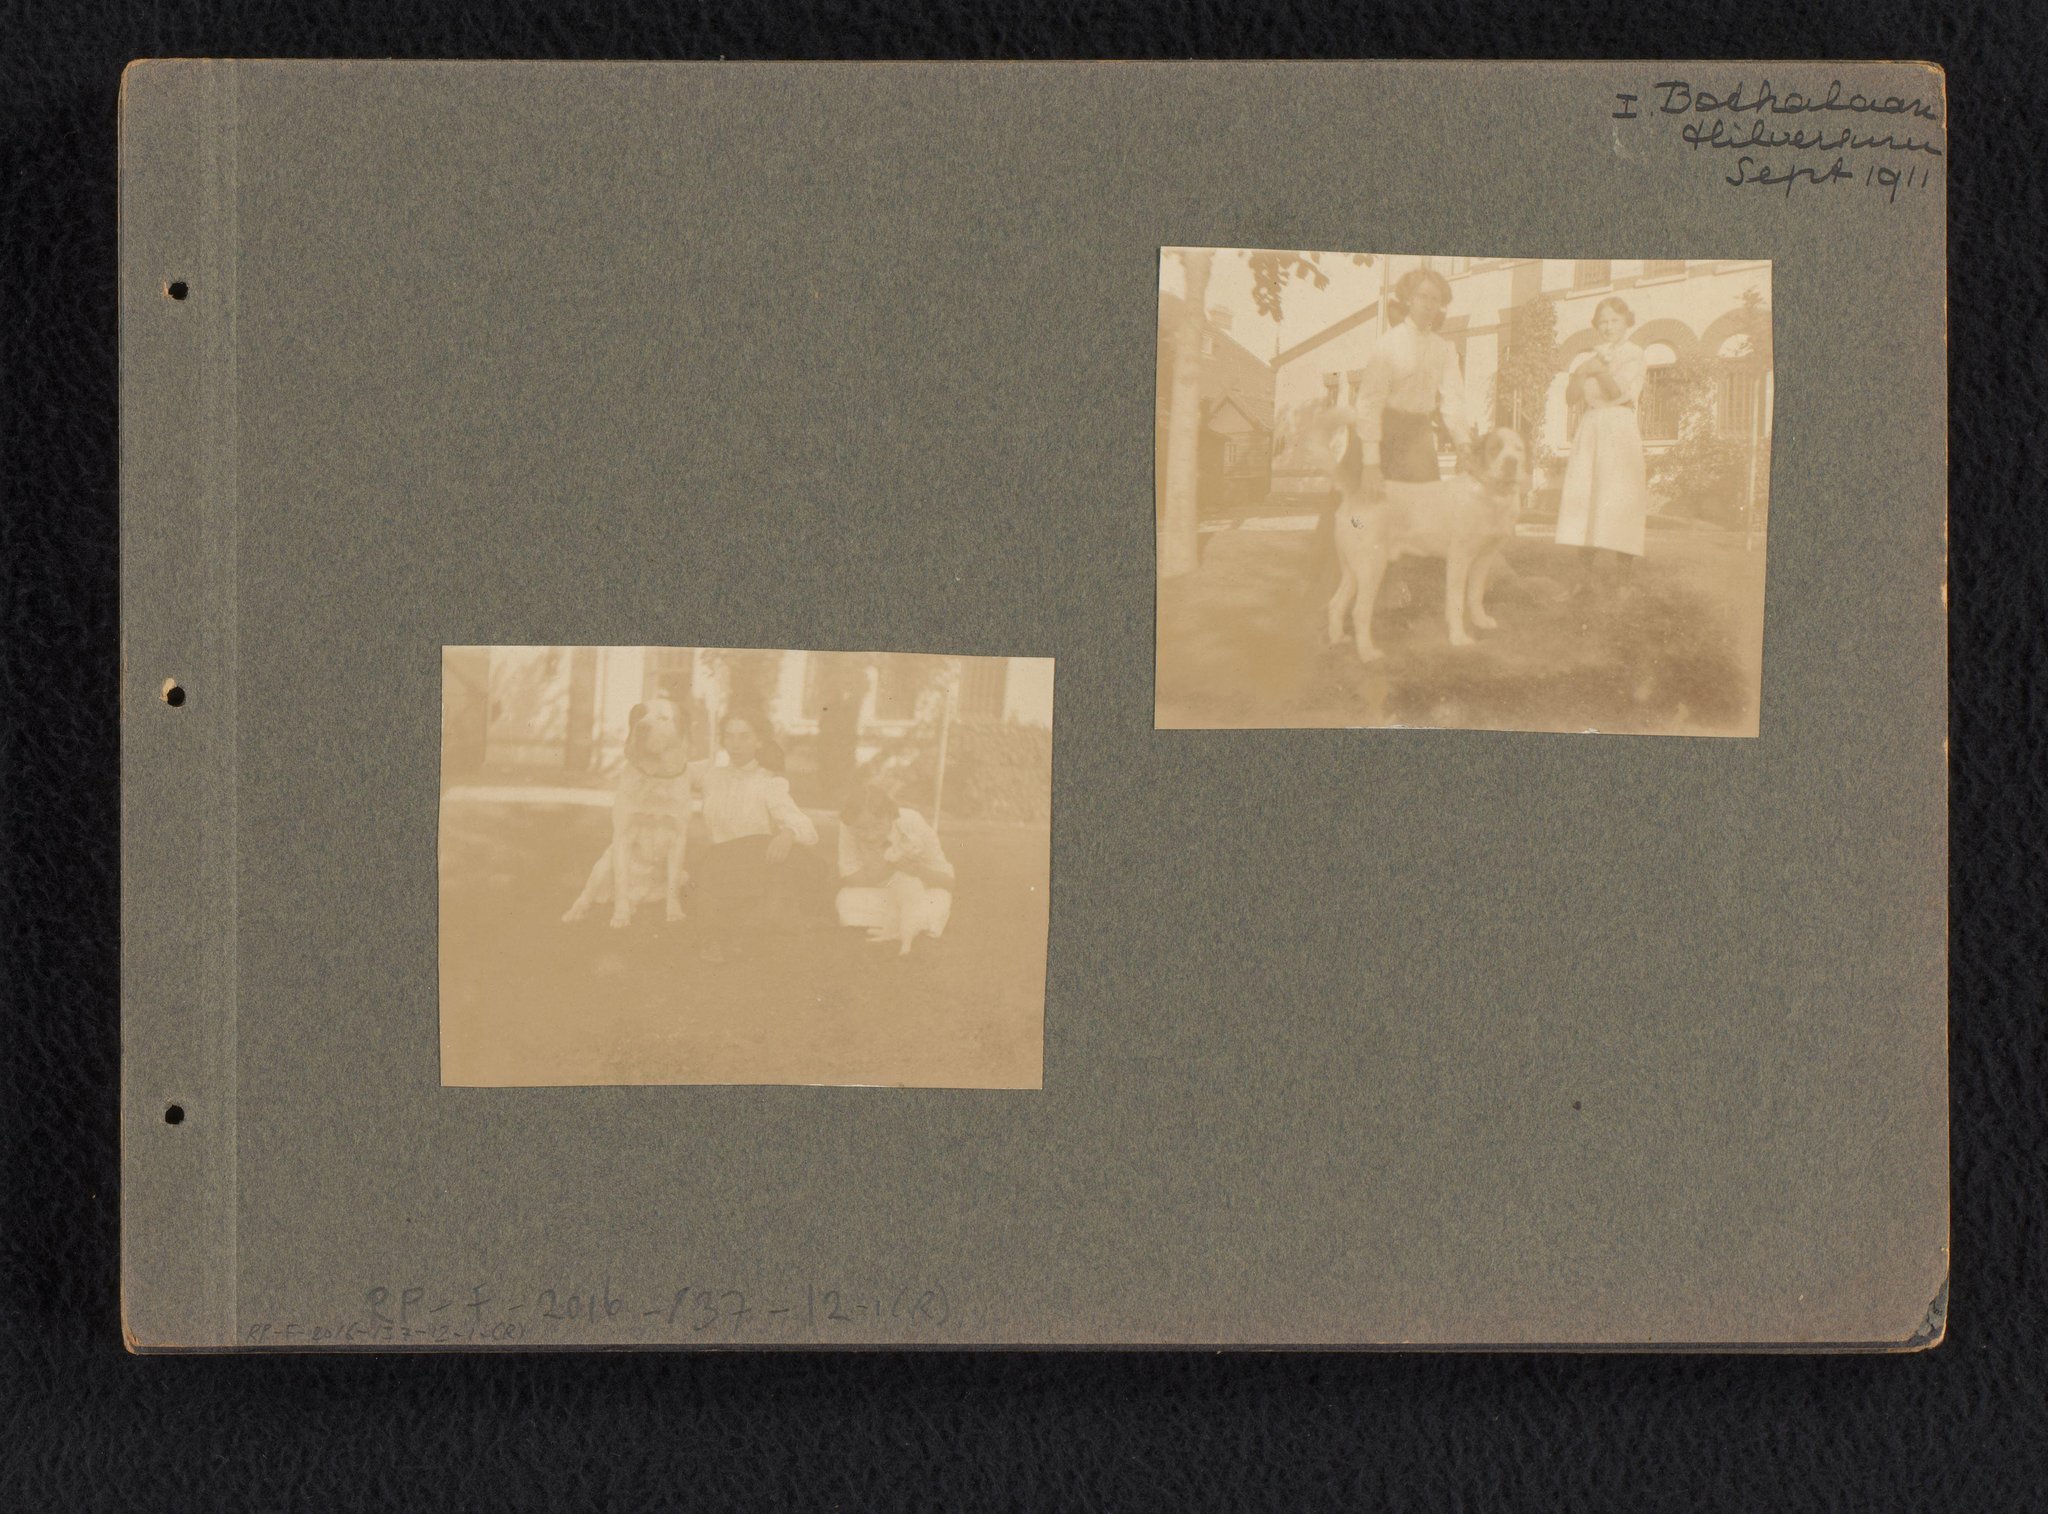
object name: photograph album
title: Ongebonden fotoalbum van het gezin Onnen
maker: carolina frederika onnen (lien/loen)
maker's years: 1896-1983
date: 1911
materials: paper, cardboard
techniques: gelatin silver print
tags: family life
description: Ongebonden fotoalbum van het gezin Onnen, bestaande uit dertien losse albumbladen en drie losse foto's.